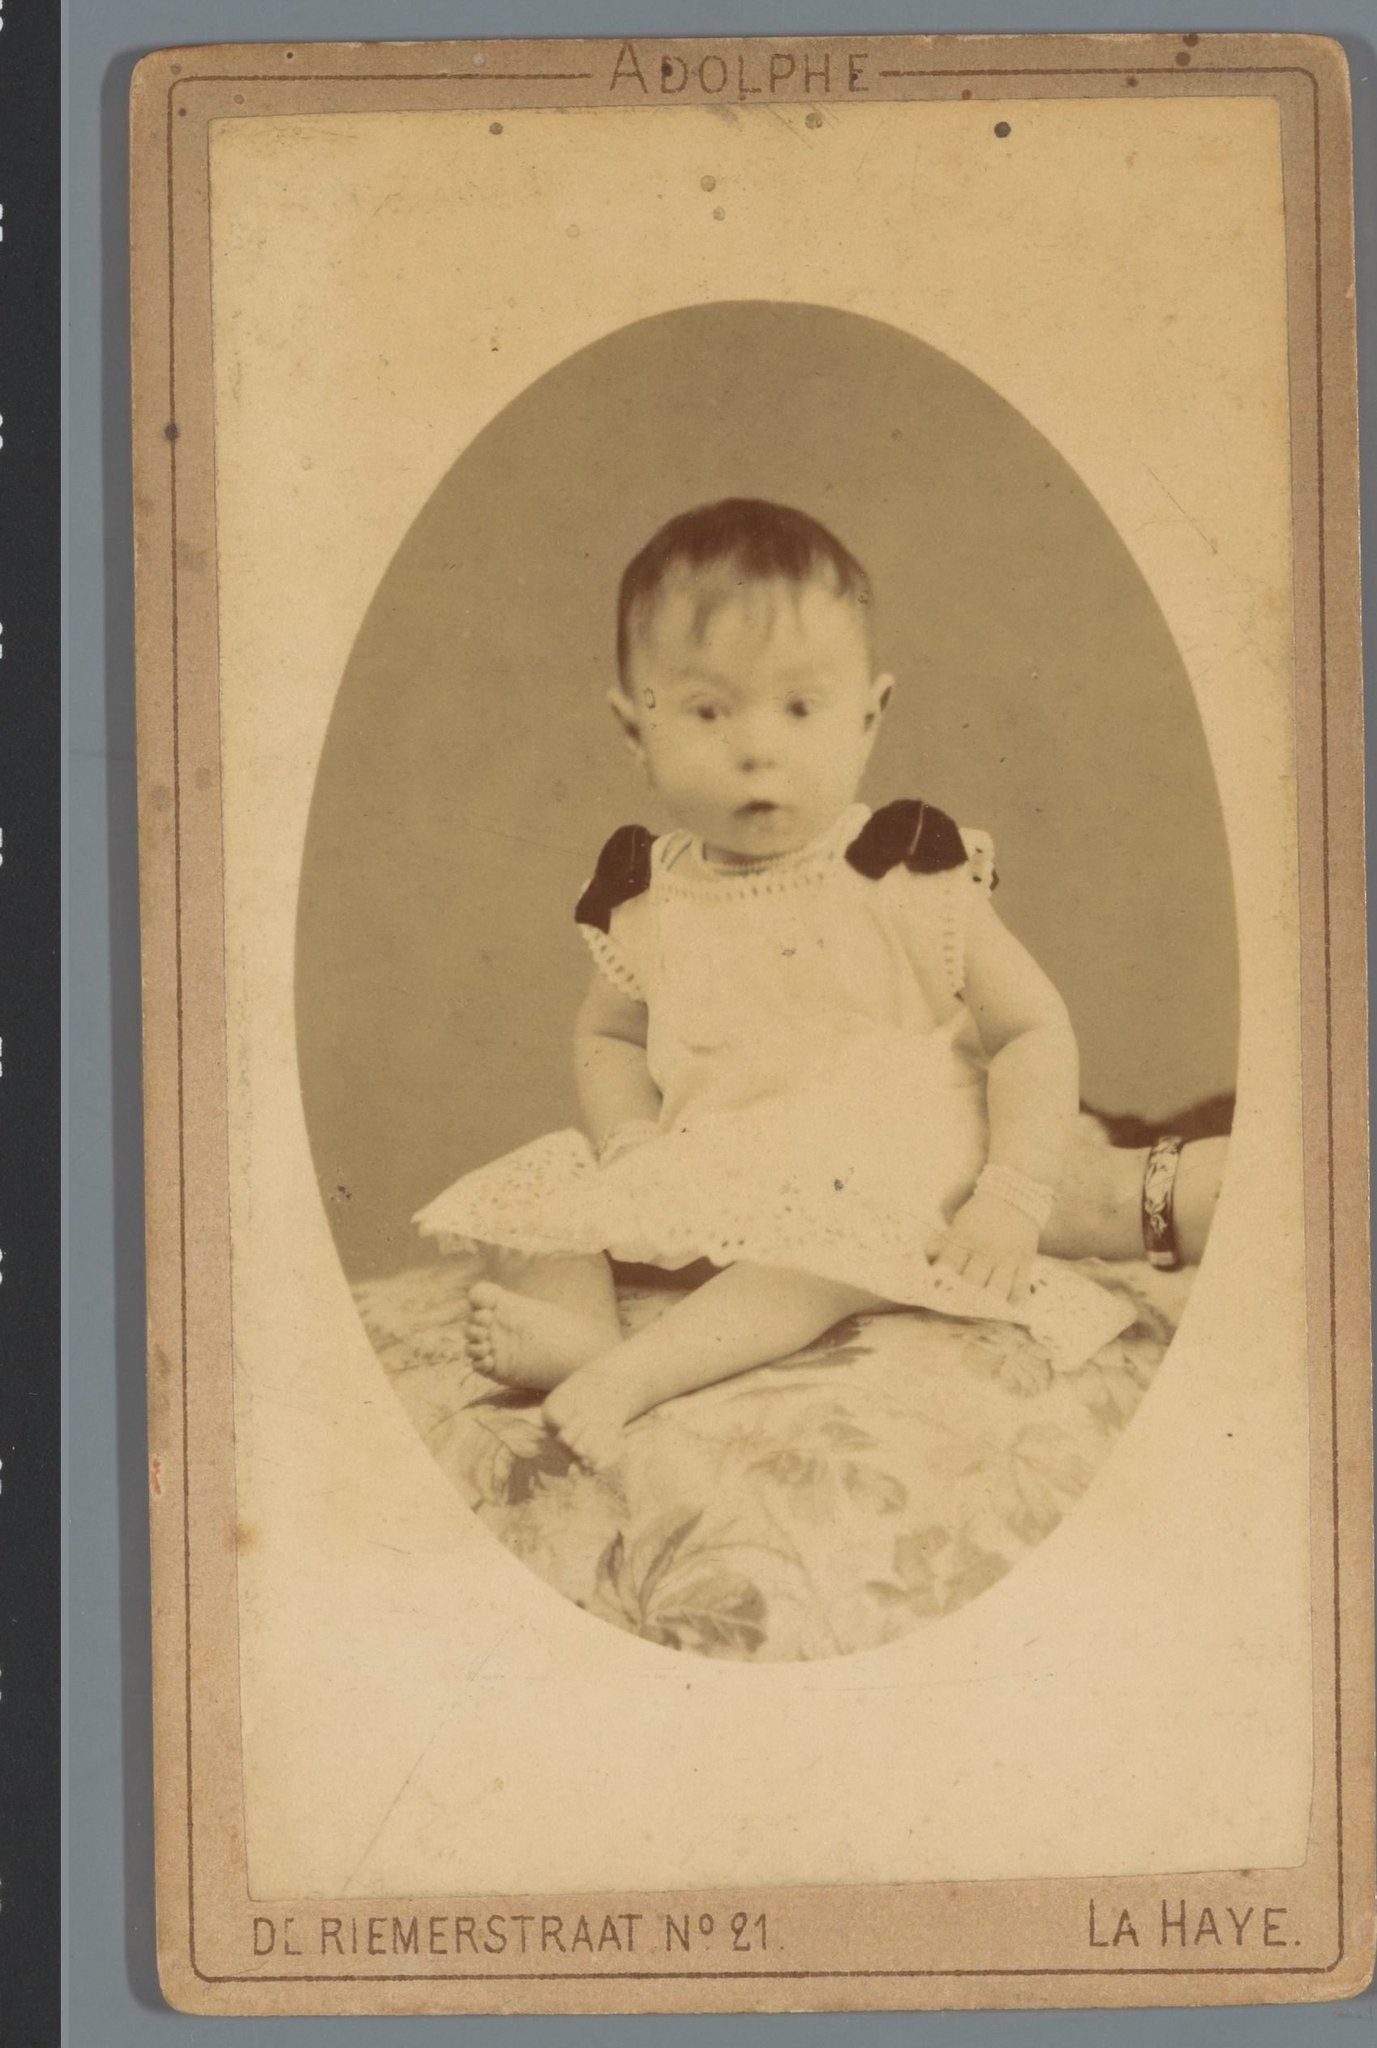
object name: photograph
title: Portret van een onbekende baby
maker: adolphe zimmermans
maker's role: fotograaf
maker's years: 1858-1922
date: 1885-1913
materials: cardboard, paper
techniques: albumen print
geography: the hague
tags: anonymous historical person portrayed, infant, baby ~ the ages of man, the hague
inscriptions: inscription: ‘Adolphe/ De Riemerstraat No. 21. La Haye.’, inscription: ‘Anvers 1885./ Adolphe Zimmermans/ Photographe./ De Riemerstraat No. 21./ La Haye.’